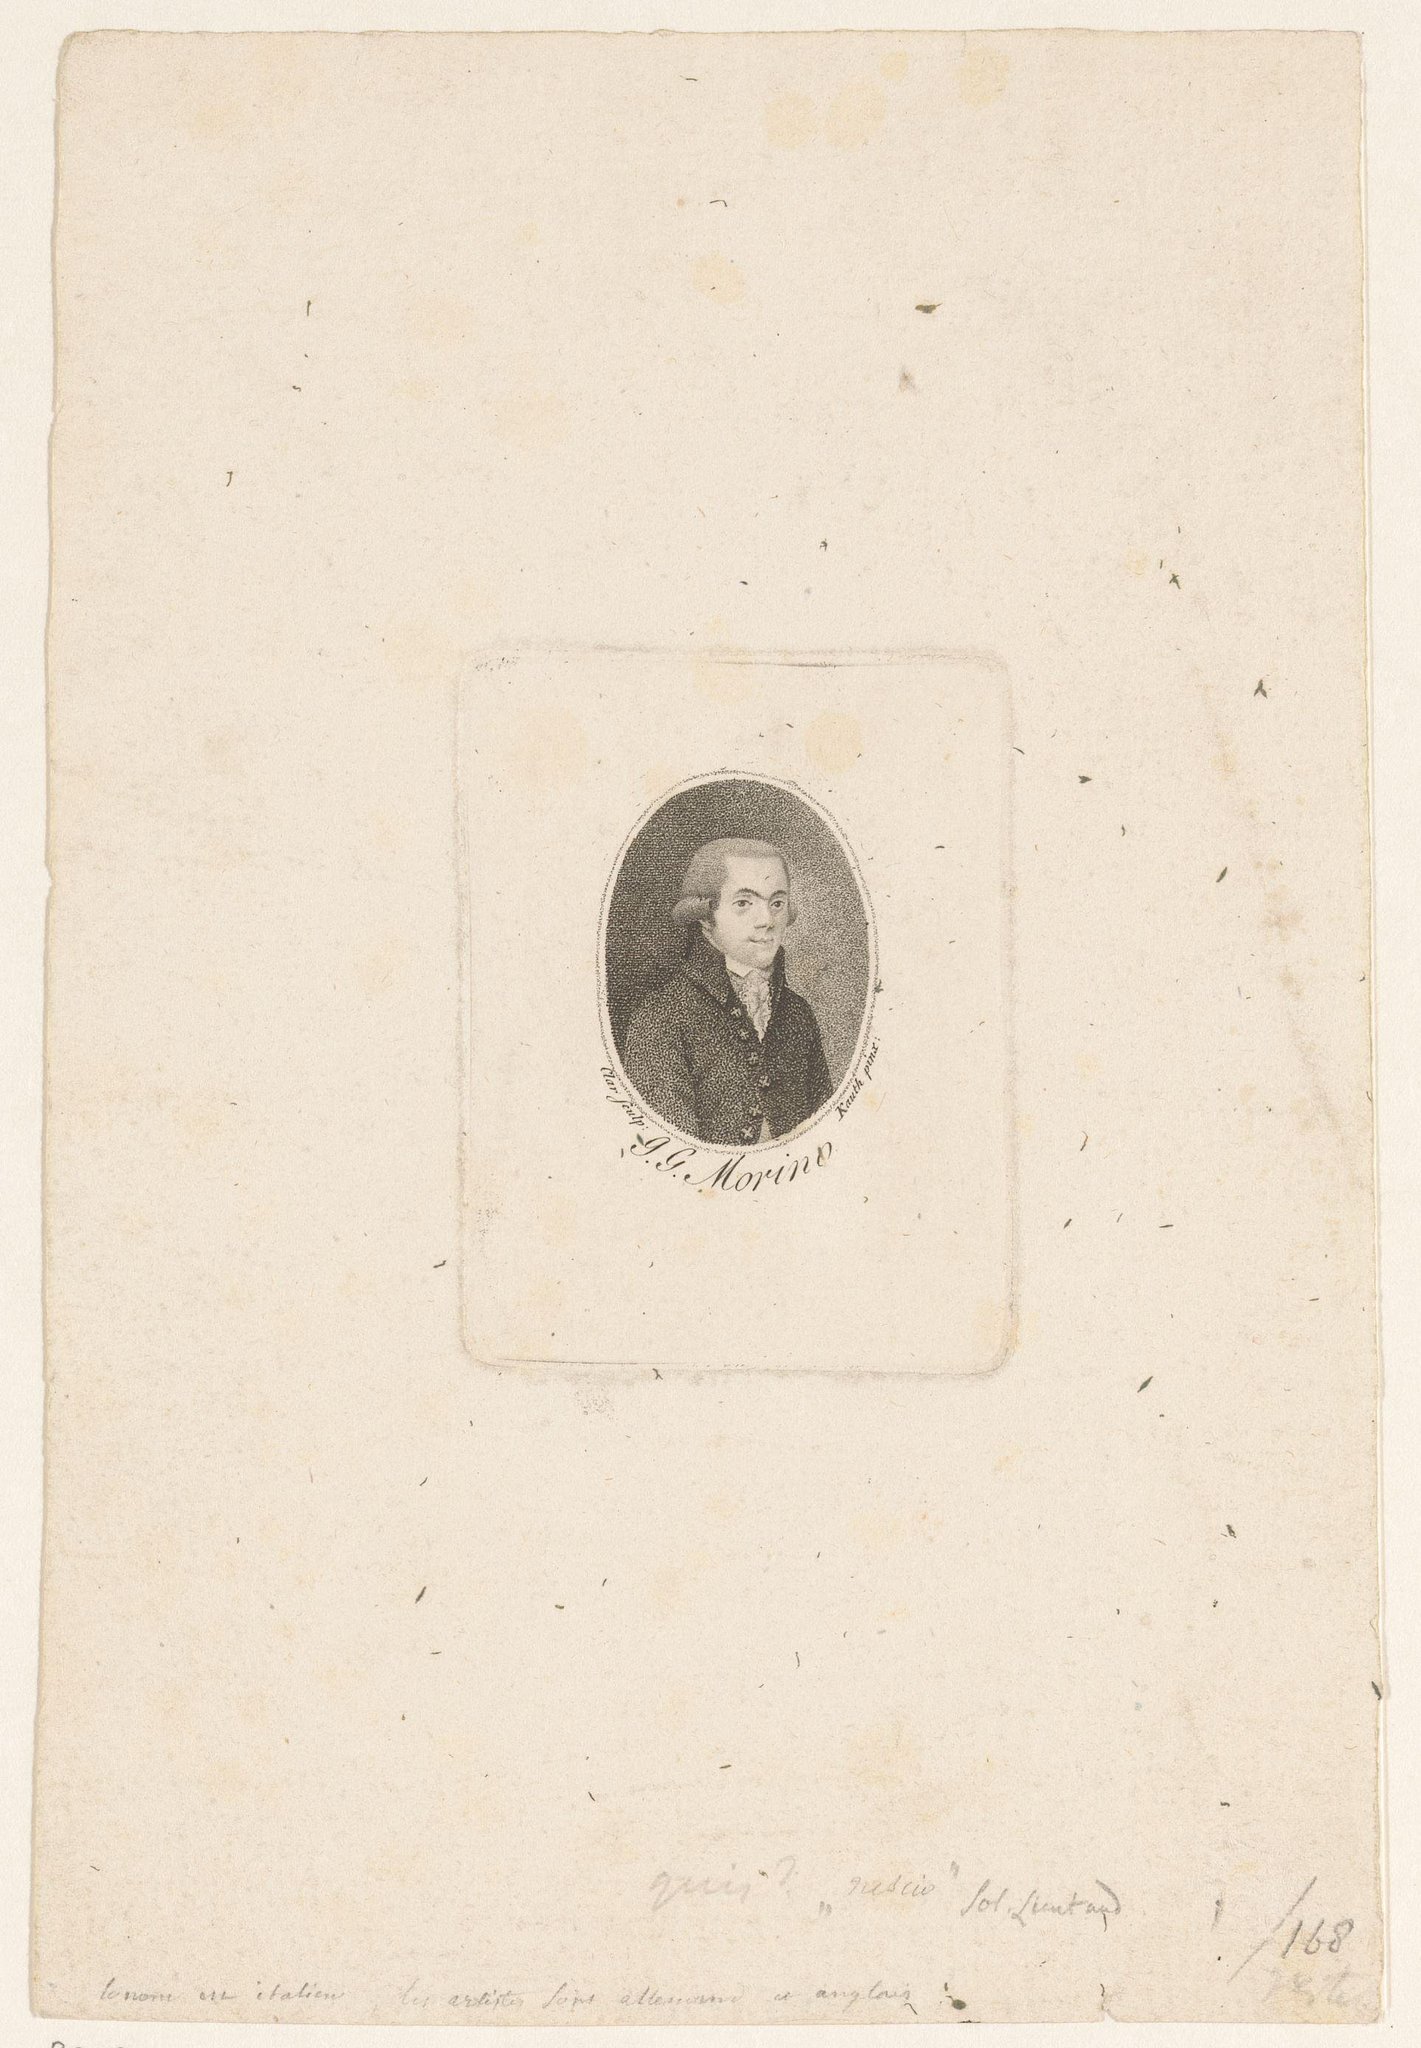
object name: print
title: Portret van J.G. Morino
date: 1778-1844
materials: paper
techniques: stippling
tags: historical persons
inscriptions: inscription: ‘"Juillet 1805" Sol. Lieutaud. J.T.B.N.’, collector's mark: Lugt 2228